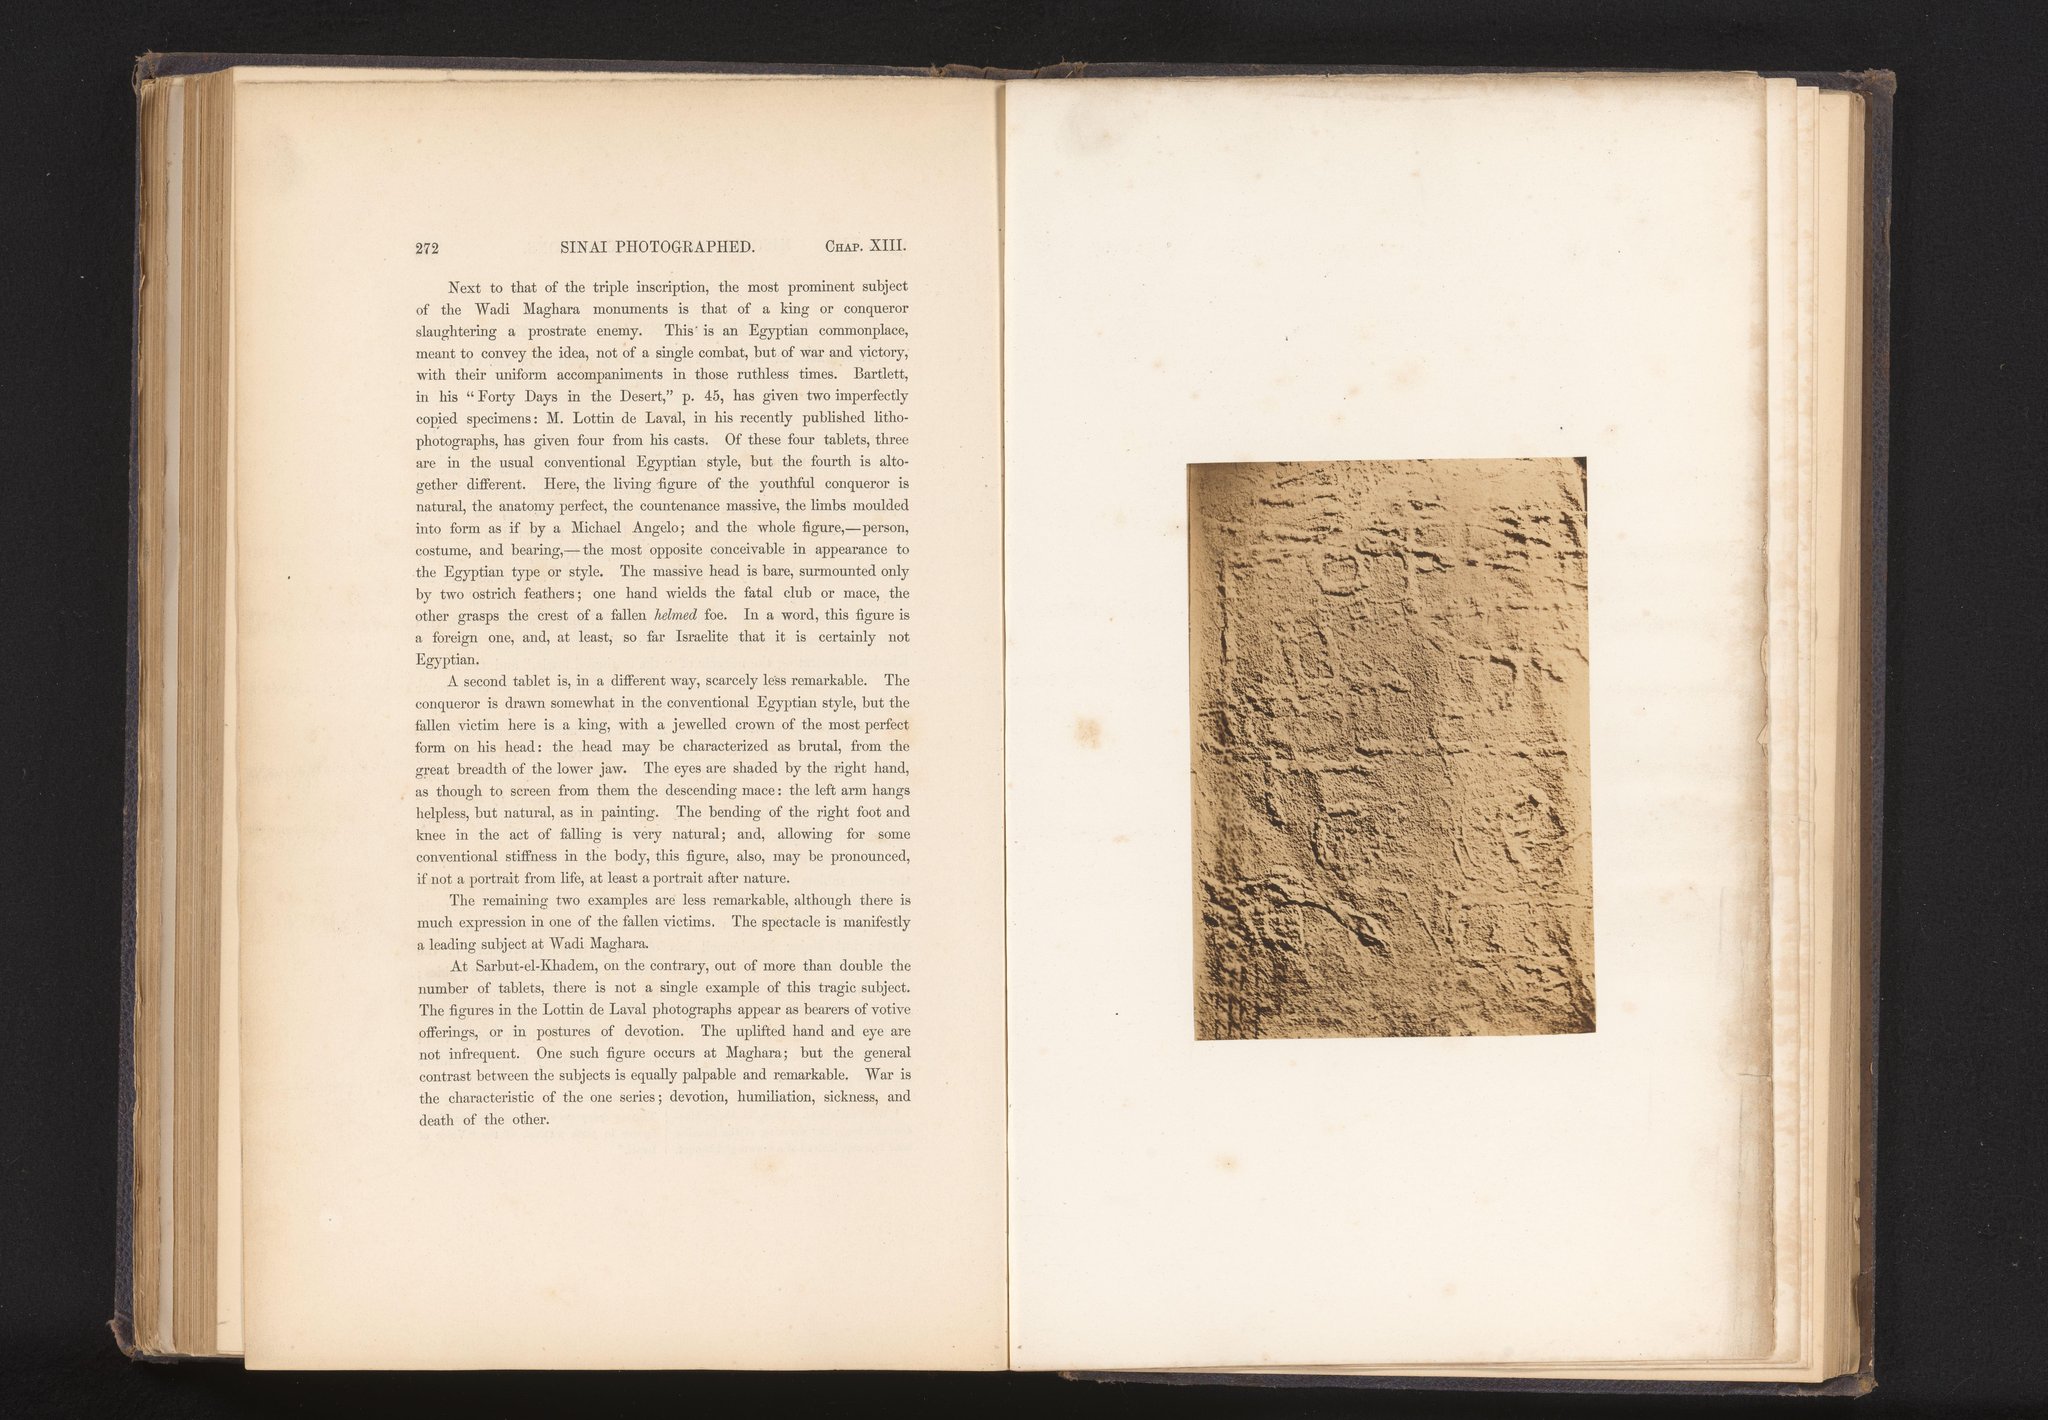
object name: page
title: Five Hieroglyphic Tablets from Wadi Maghara (Photographed from casts taken by the Rev. Pierce Butler)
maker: a.j. brown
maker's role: fotograaf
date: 1857-1862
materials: paper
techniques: albumen print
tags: egyptian hieroglyphs